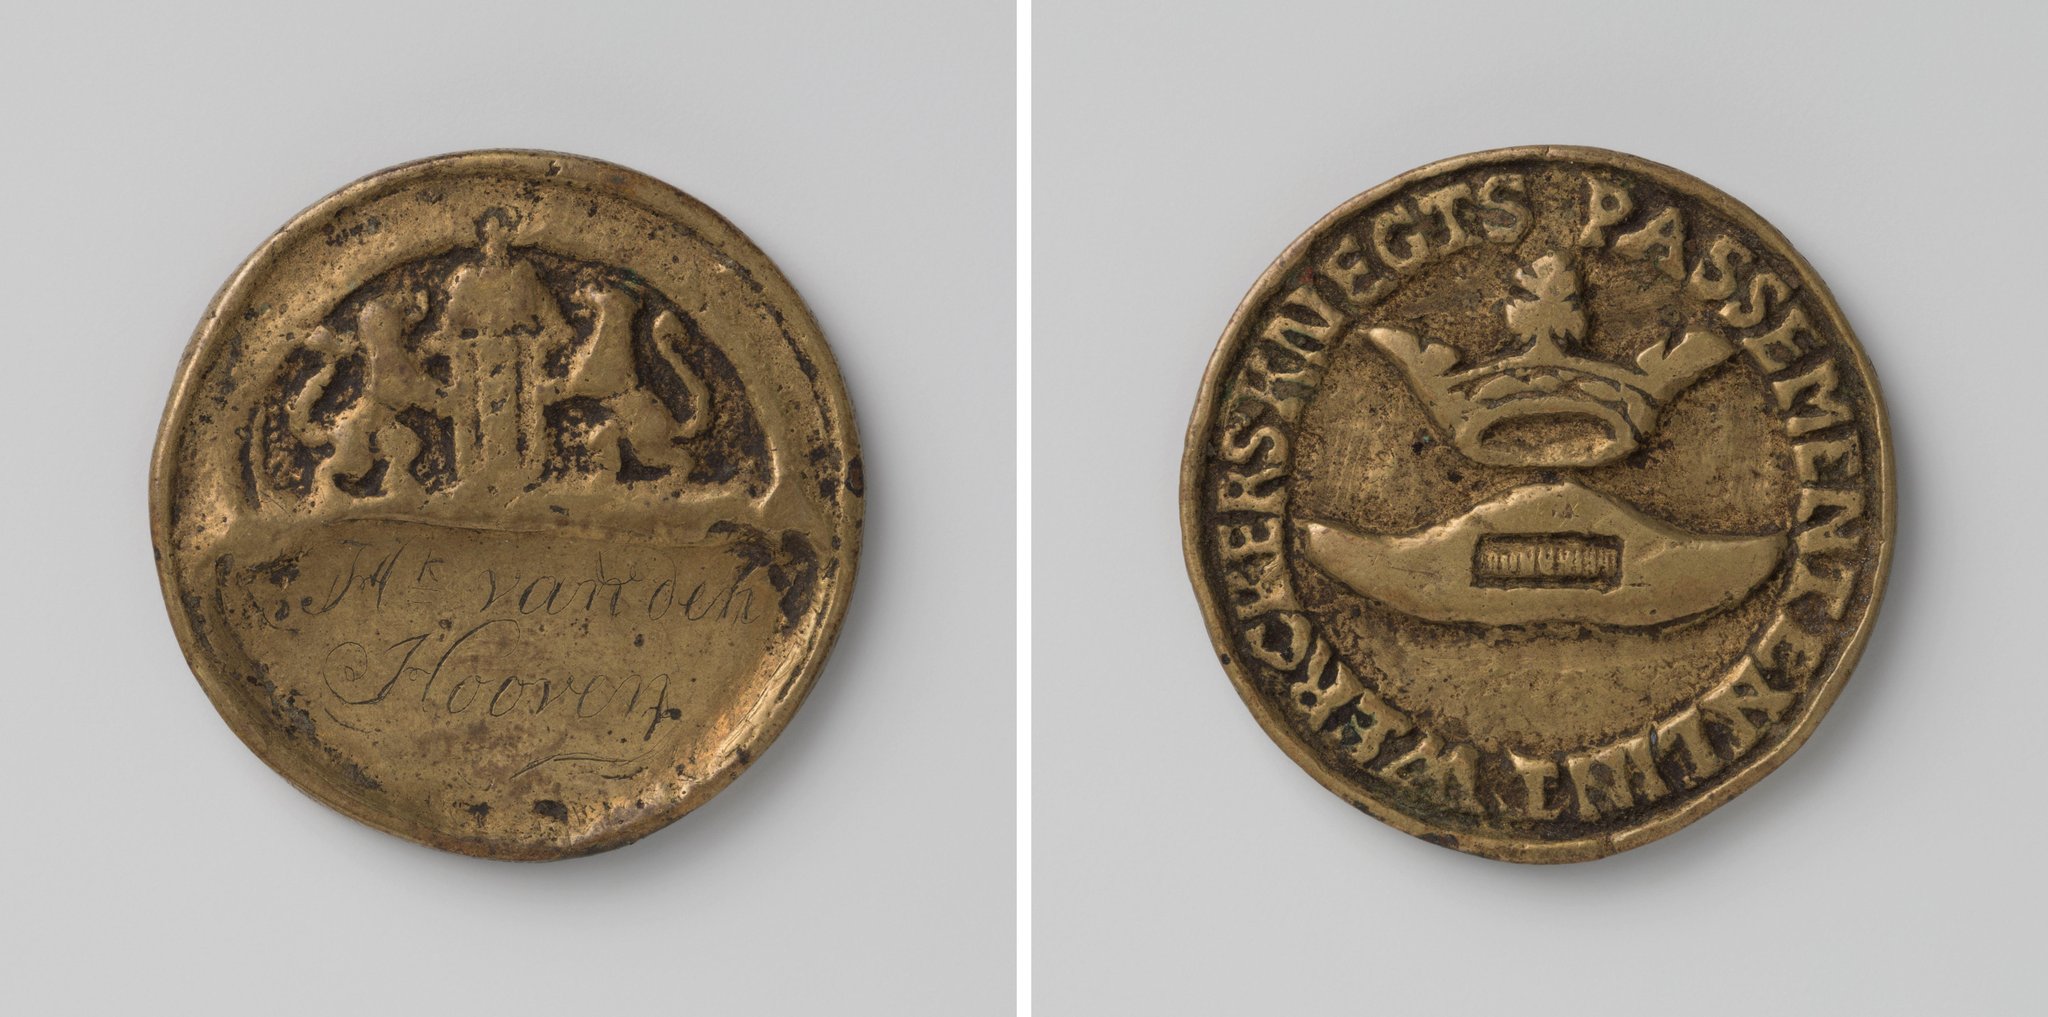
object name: medal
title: Knechts van het passement- en lintwerkersgilde van Amsterdam, gildepenning van Hendrik van den Hooven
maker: Anonymous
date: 1700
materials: brass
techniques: casting, engraving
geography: amsterdam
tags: amsterdam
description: Messing penning. Voorzijde: gekroond wapenschild, geflankeerd door twee leeuwen boven cartouche met opschrift. Keerzijde: weversspoel onder kroon binnen omschrift.